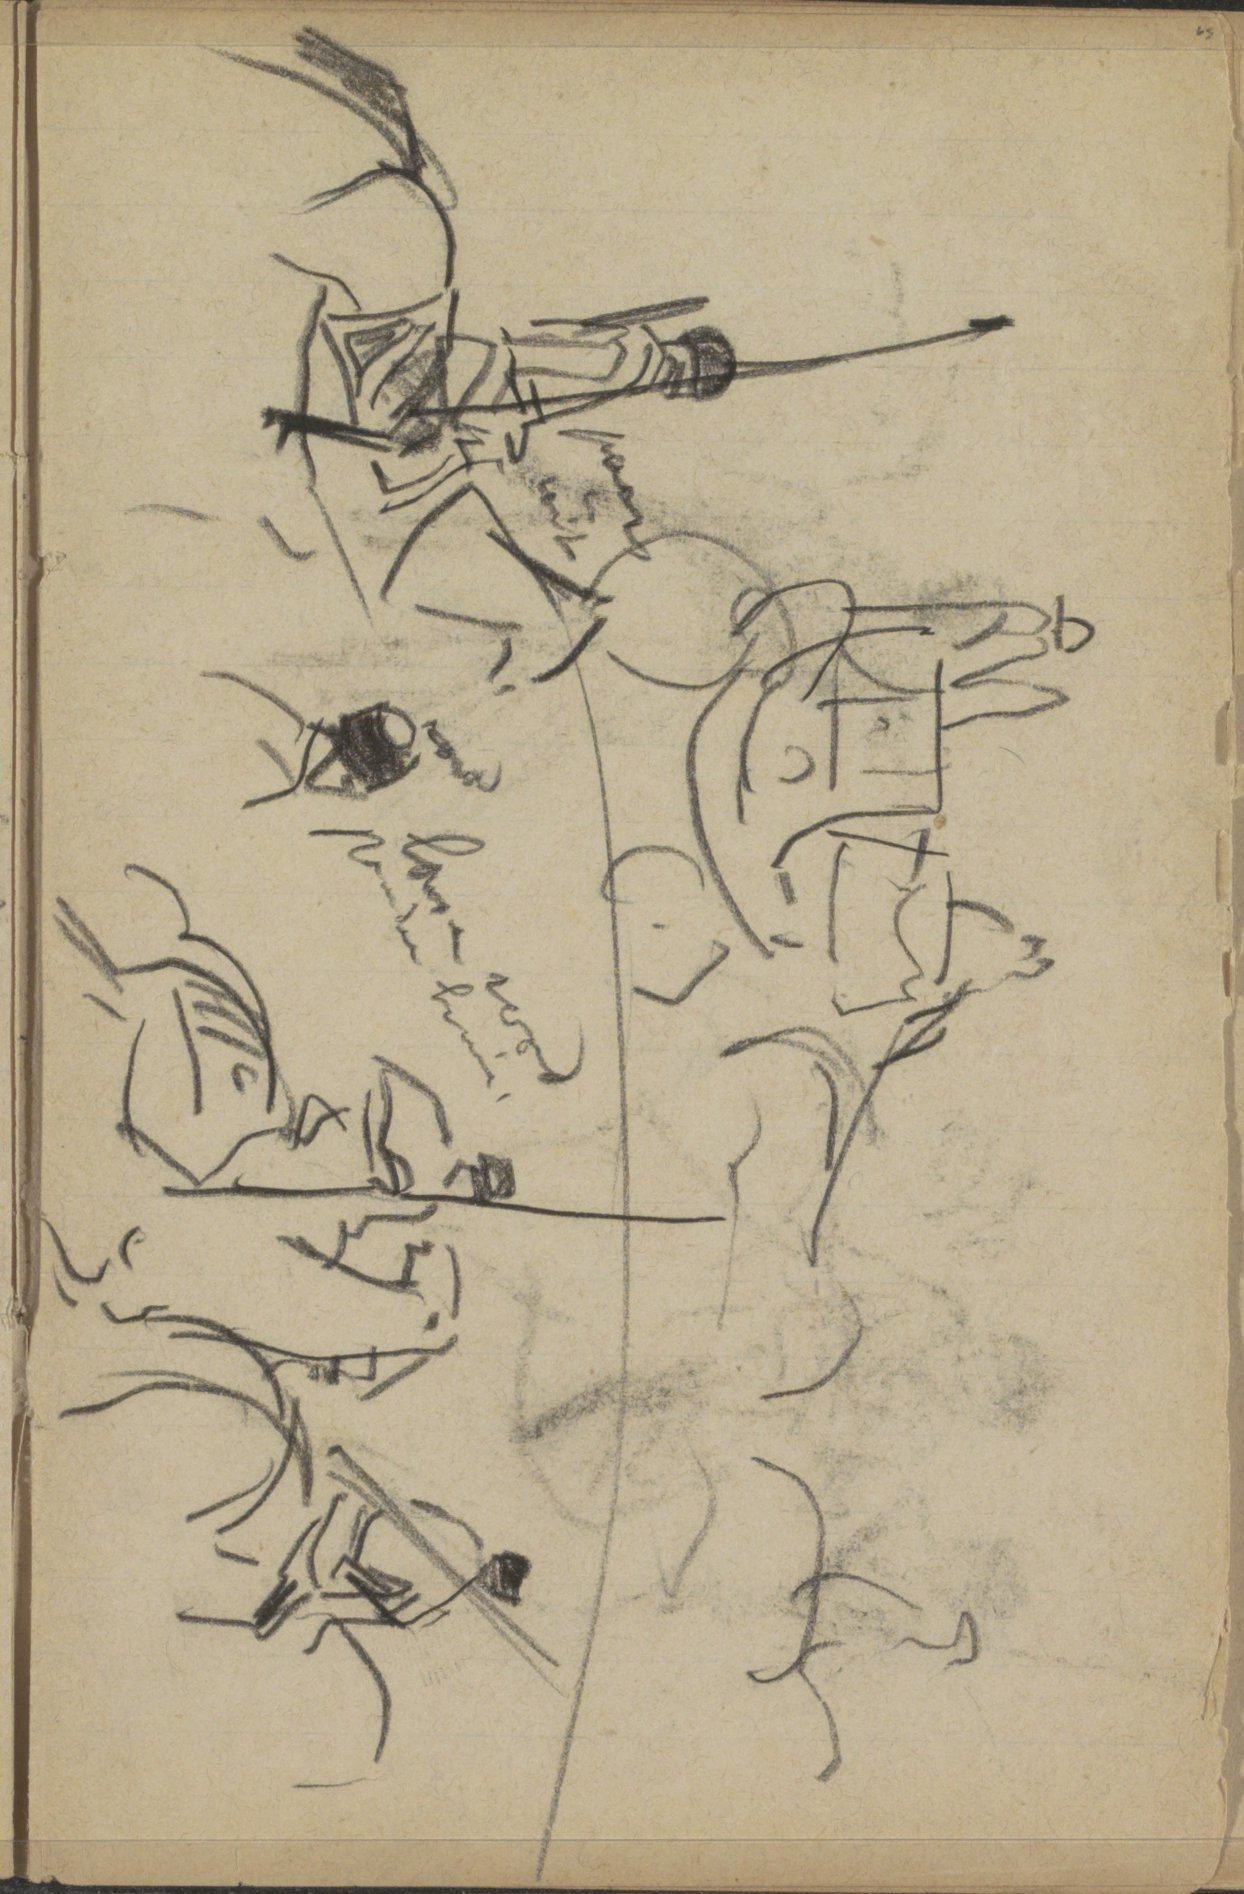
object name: sketchbook leaf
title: Optocht met een koets en militairen te paard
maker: marius bauer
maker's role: draughtsman, print maker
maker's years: 1867-1932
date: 1896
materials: chalk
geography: moscow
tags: riding a horse, ass, or mule; rider, horseman, four-wheeled, animal-drawn vehicle, e.g.: cab, carriage, coach, (military) uniforms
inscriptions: kleurnotitie, handgeschreven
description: De koets en militairen maken deel uit van de stoet voor de kroning van tsaar Nicolaas II. Pagina 65 uit een schetsboek met 50 bladen.